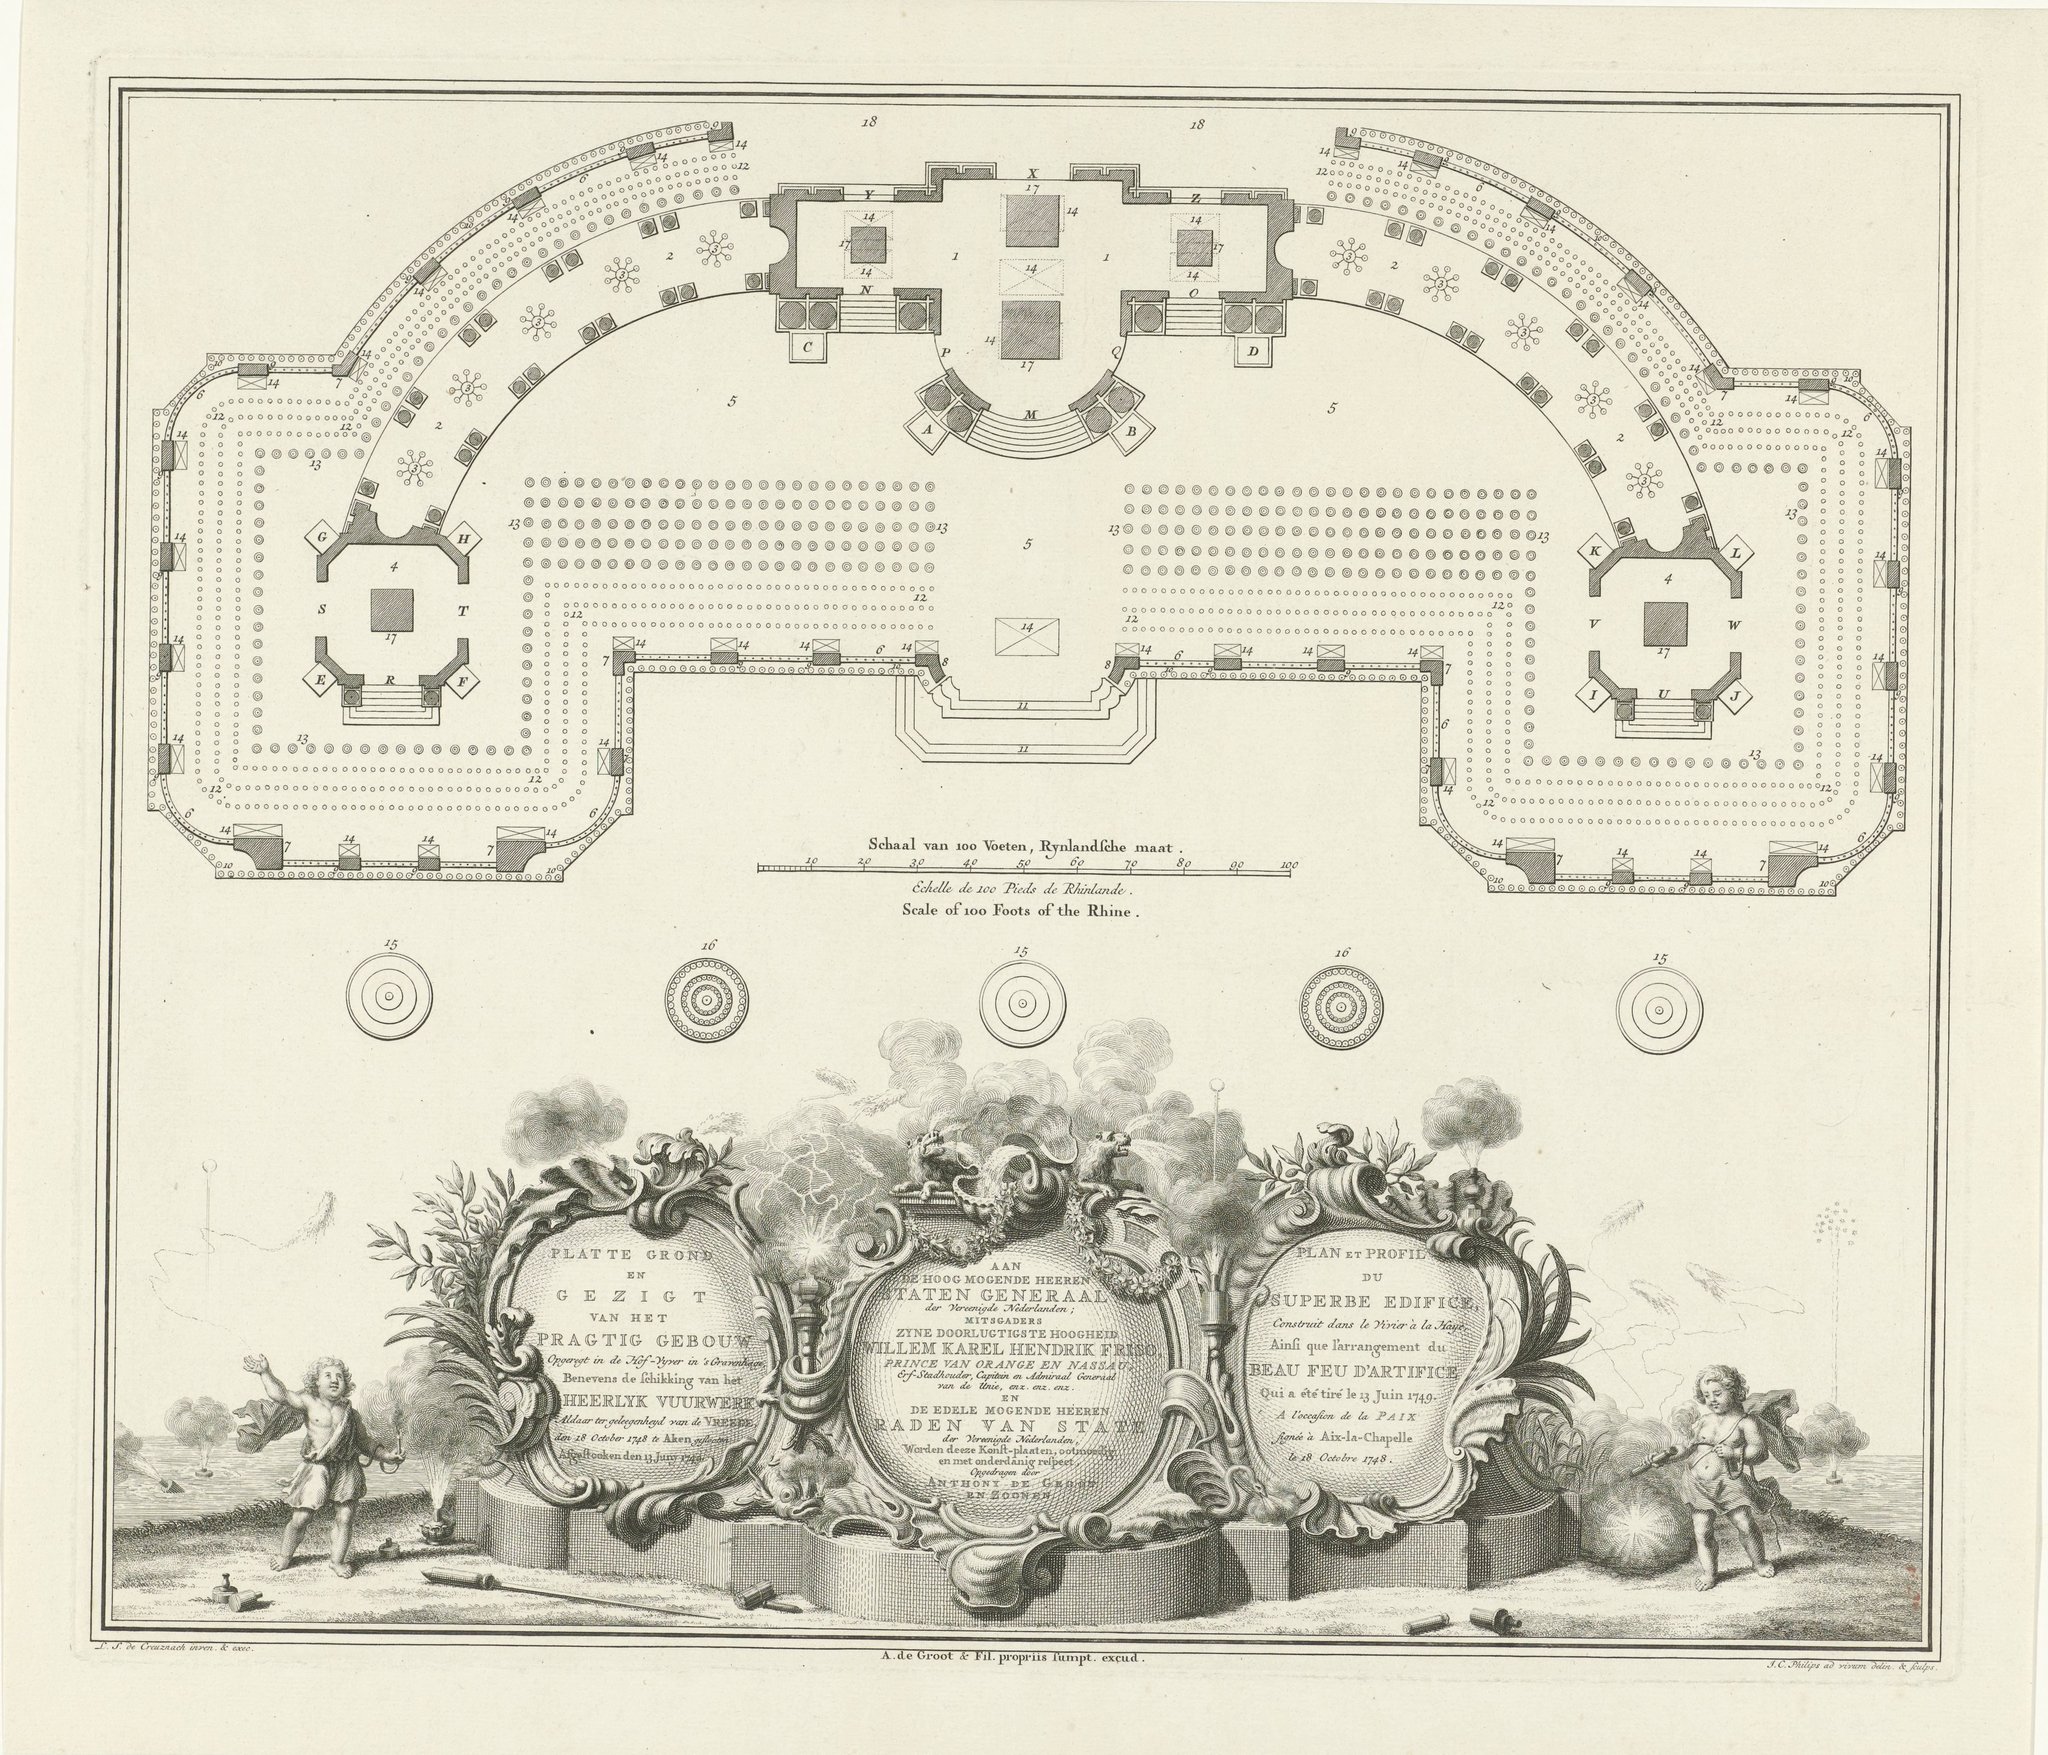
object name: print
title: Platte grond en Gezigt van het Pragtig Gebouw Opgeregt in de Hof-Vyver in s' Gravenhage, Benevens de schikking van het Heerlyk Vuurwerk Aldaar ter geleegenheyd van de Vreede den 18. October 1748 te Aken geslooten. Afgestooken den 13 Juny 1749 / Plan et Profil du Superbe Edifice, Contruit dans le Vivier à la Haye, Ainsi que l'arrangement du Beau Feu d'Artifice Qui a été tiré le 13 Juin 1749 (...)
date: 1749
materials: paper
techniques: engraving, etching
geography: the hague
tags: plan ~ architecture, bonfire, fire-works (+ illumination, fire-works ~ festive activities)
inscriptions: collector's mark: Lugt 240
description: Plattegrond van het grote theater opgericht in de Hofvijver te Den Haag. Het werd op 13 juni 1749 gebruikt voor het vuurwerk ter ere van de Vrede van Aken gesloten in 1748. Onderaan cartouches met de titels in het Nederlands en Frans en de opdrachten, met twee figuurtjes met brandende lonten. Bij de plattegrond behoren een voorstelling van het vuurwerk en een tekstblad met verklaring.